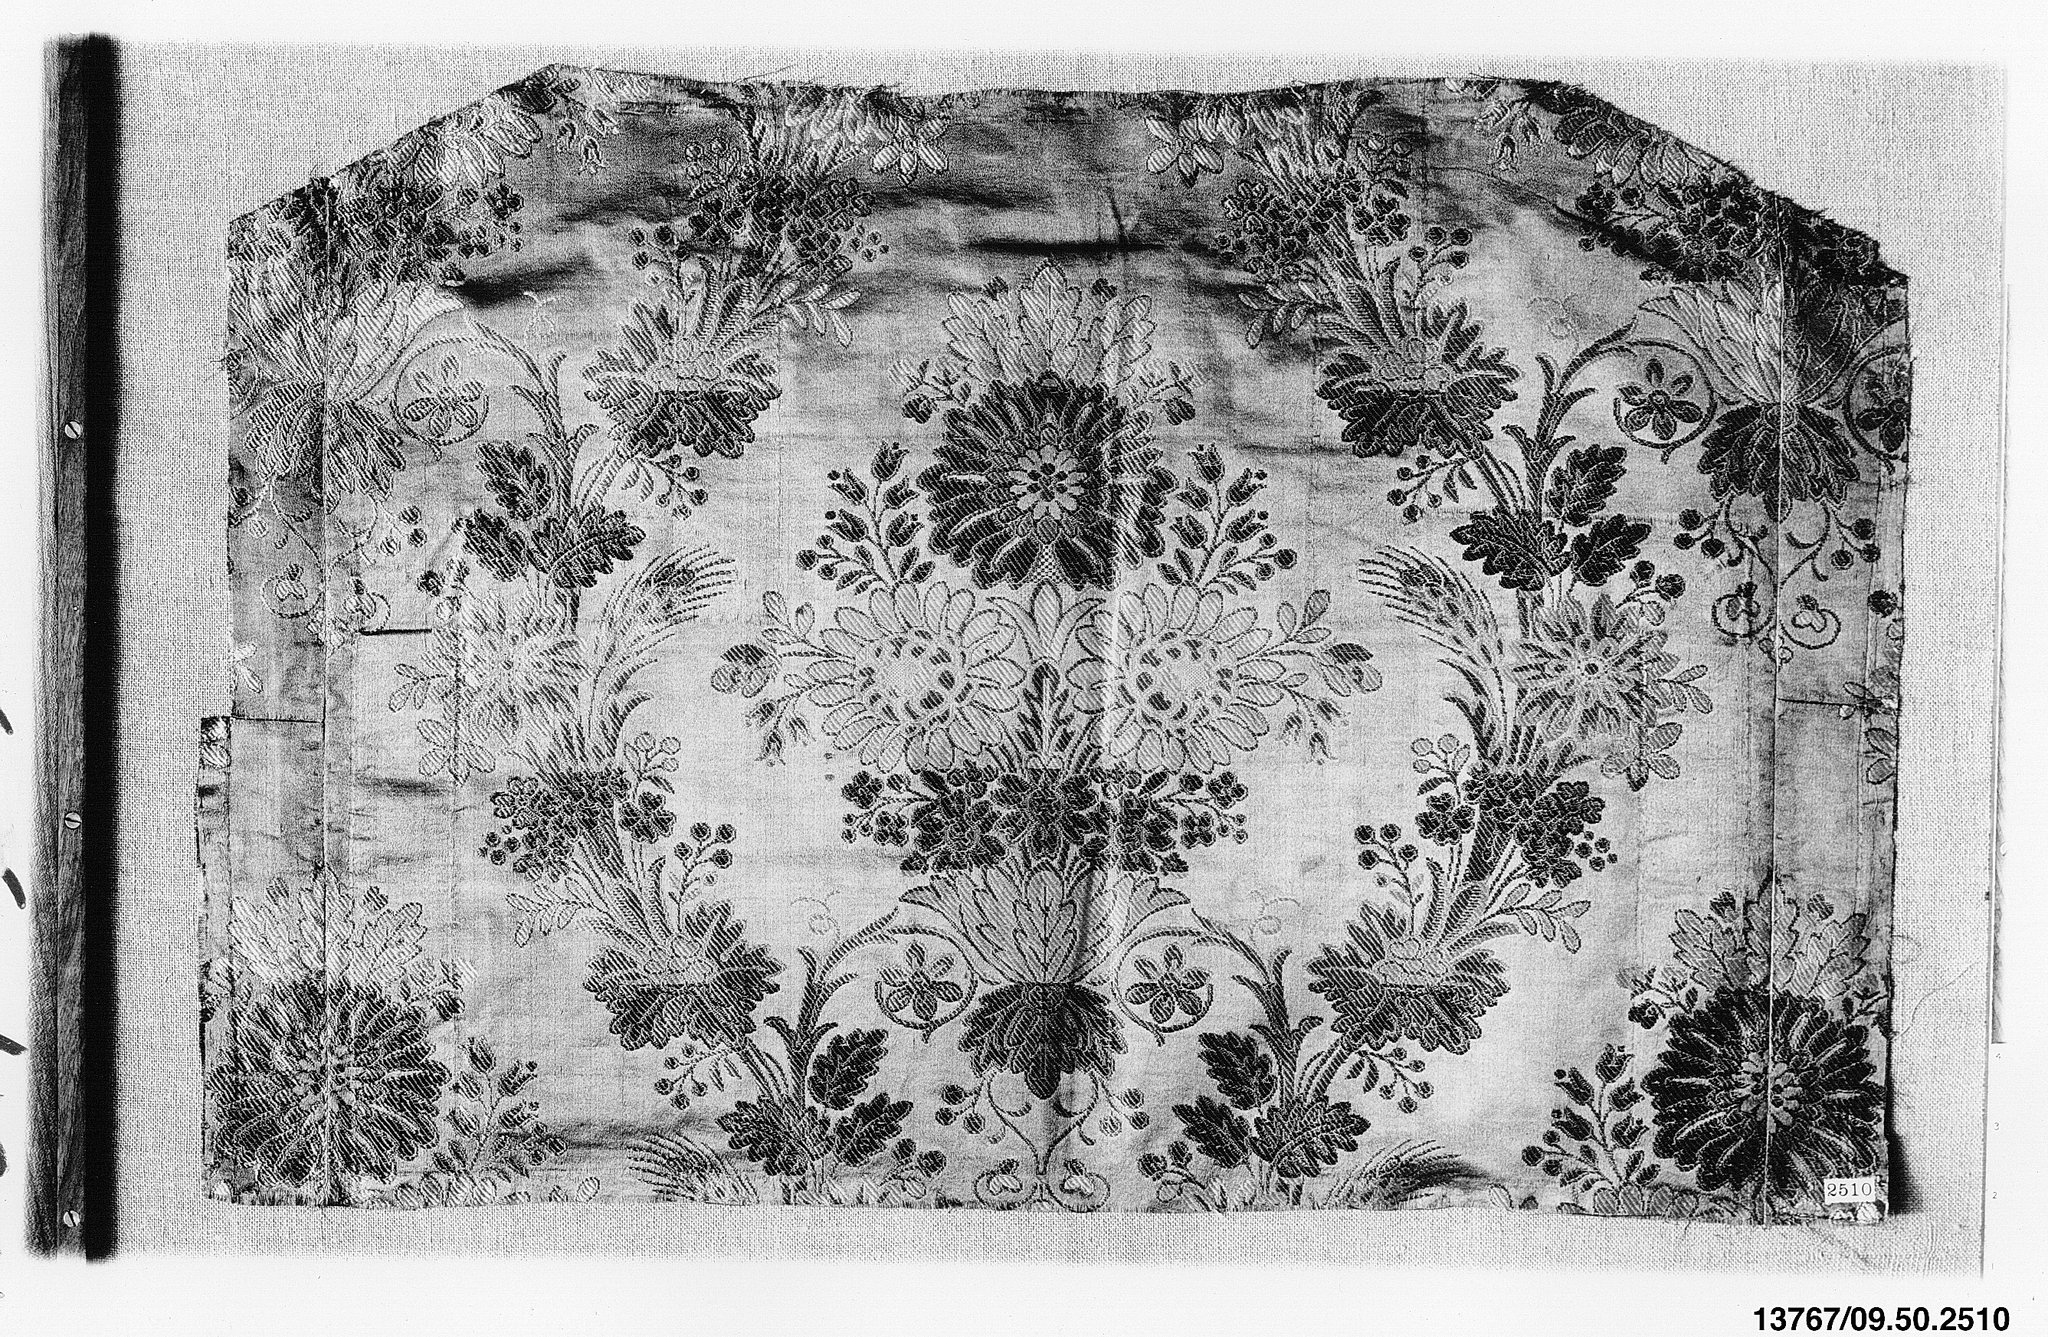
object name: piece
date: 1801-1833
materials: silk